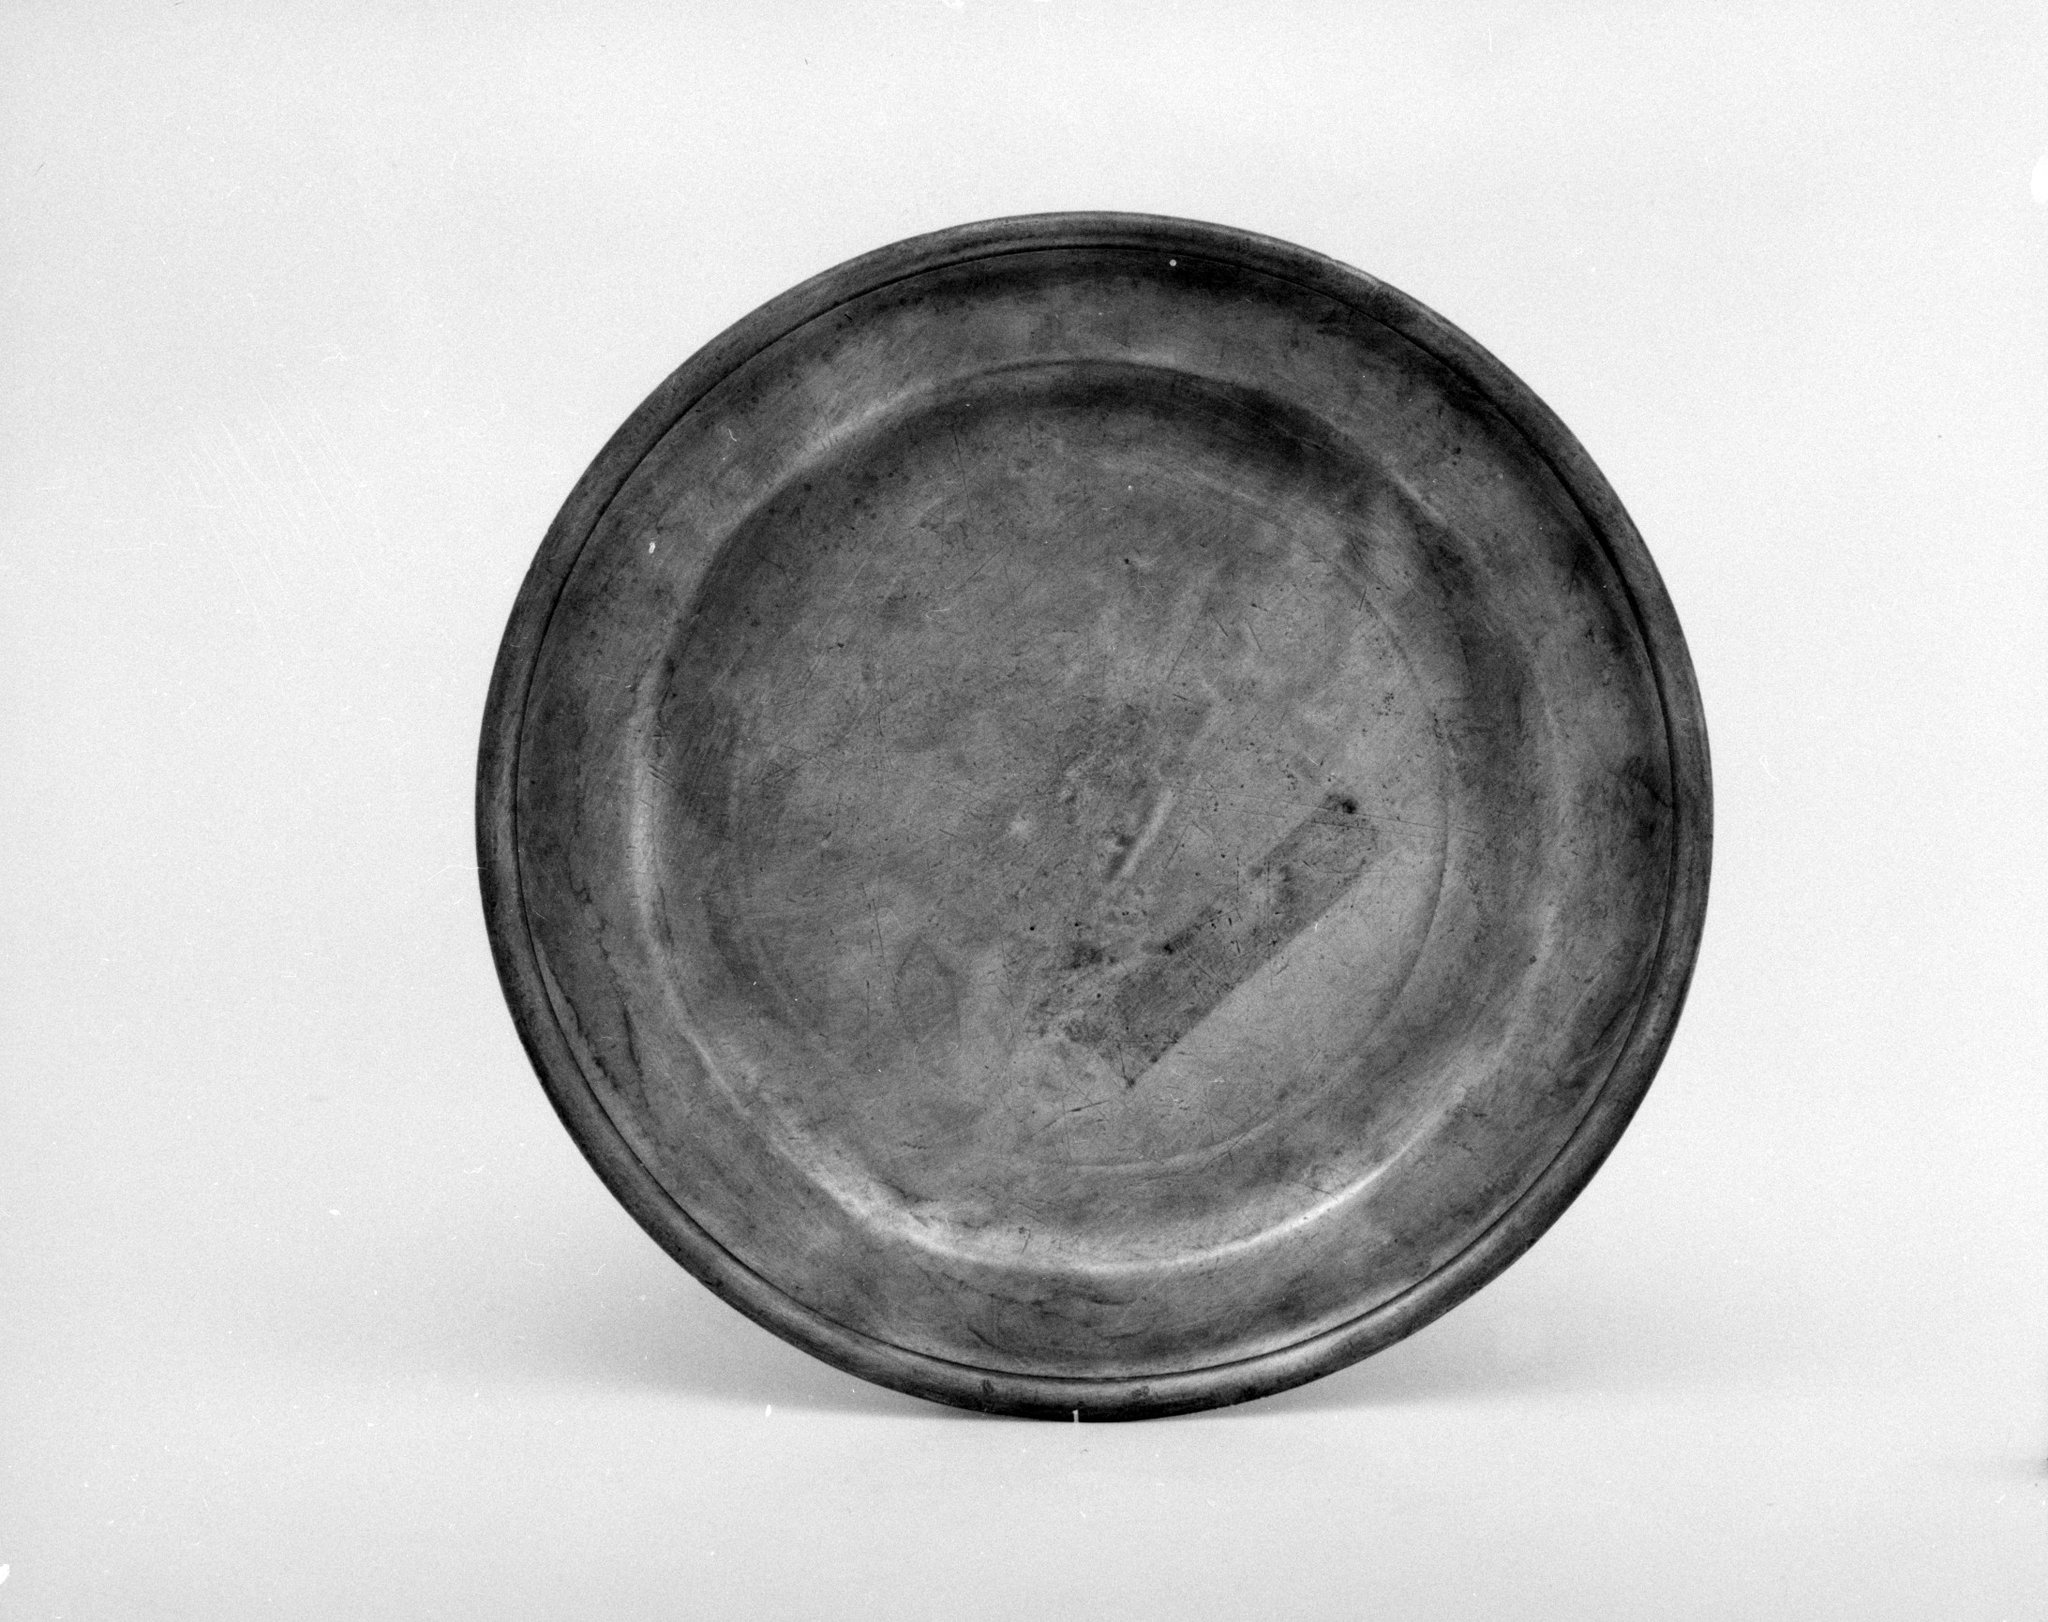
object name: plate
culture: american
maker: samuel melville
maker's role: maker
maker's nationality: american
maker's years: 1793-1800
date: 1793-1800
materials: pewter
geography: united states